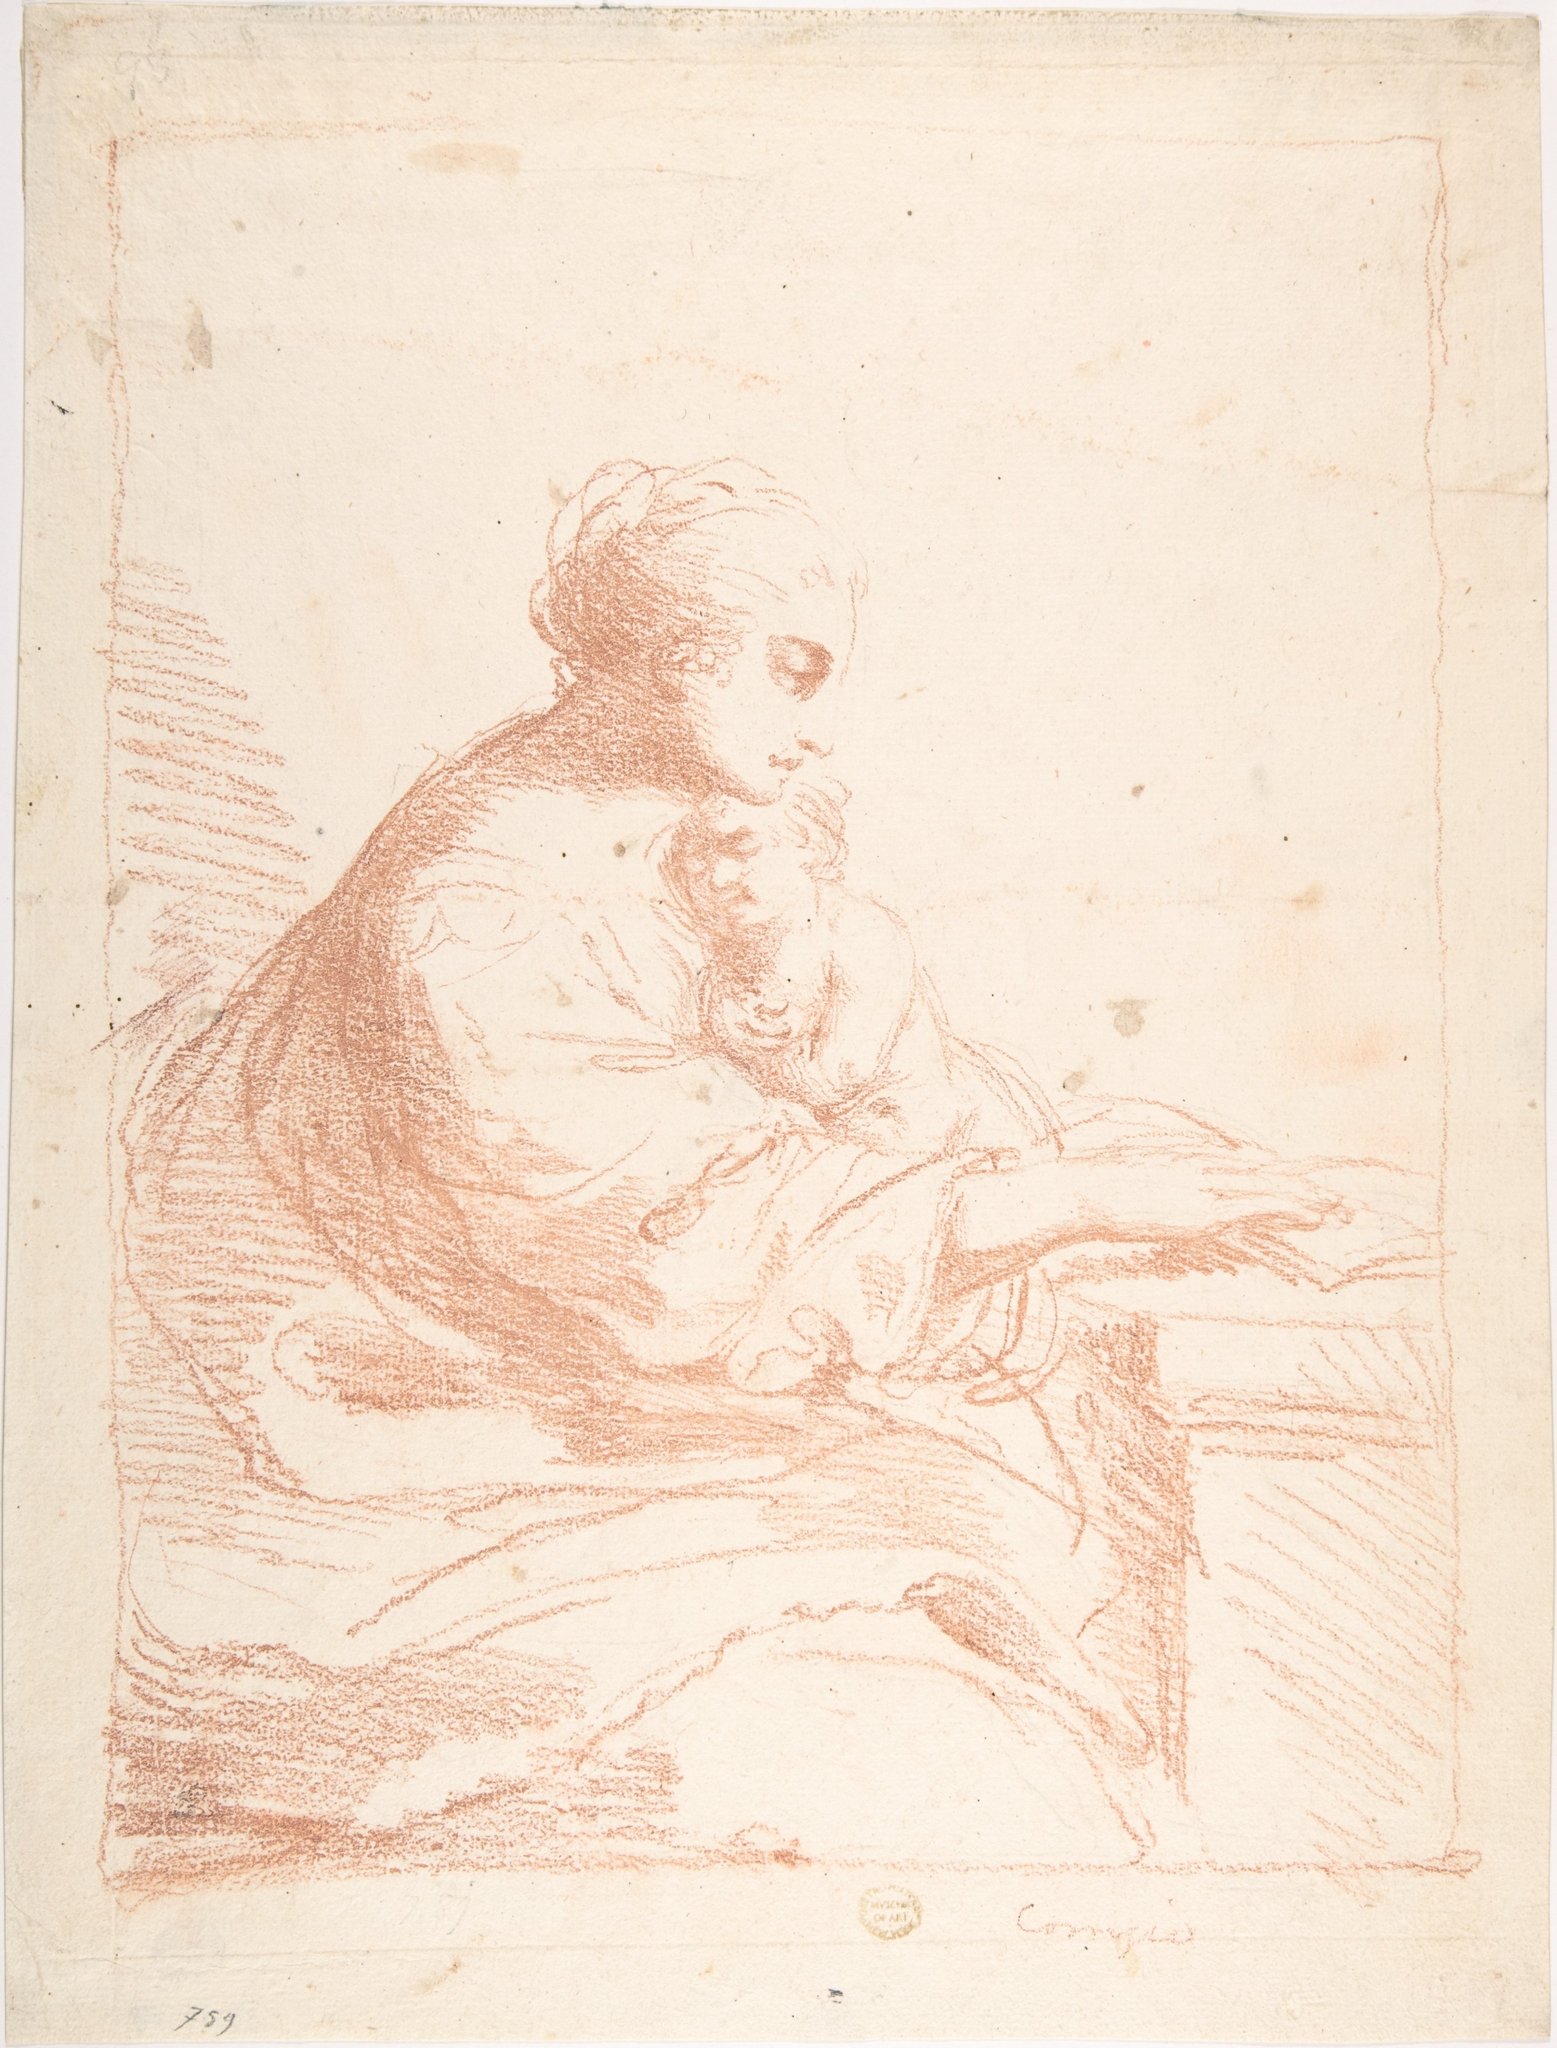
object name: drawing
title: Mother and Child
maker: anonymous, italian, roman-bolognese, 17th century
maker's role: artist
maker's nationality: italian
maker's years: 1600-1700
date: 1601-1700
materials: chalk, paper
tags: infants,mothers